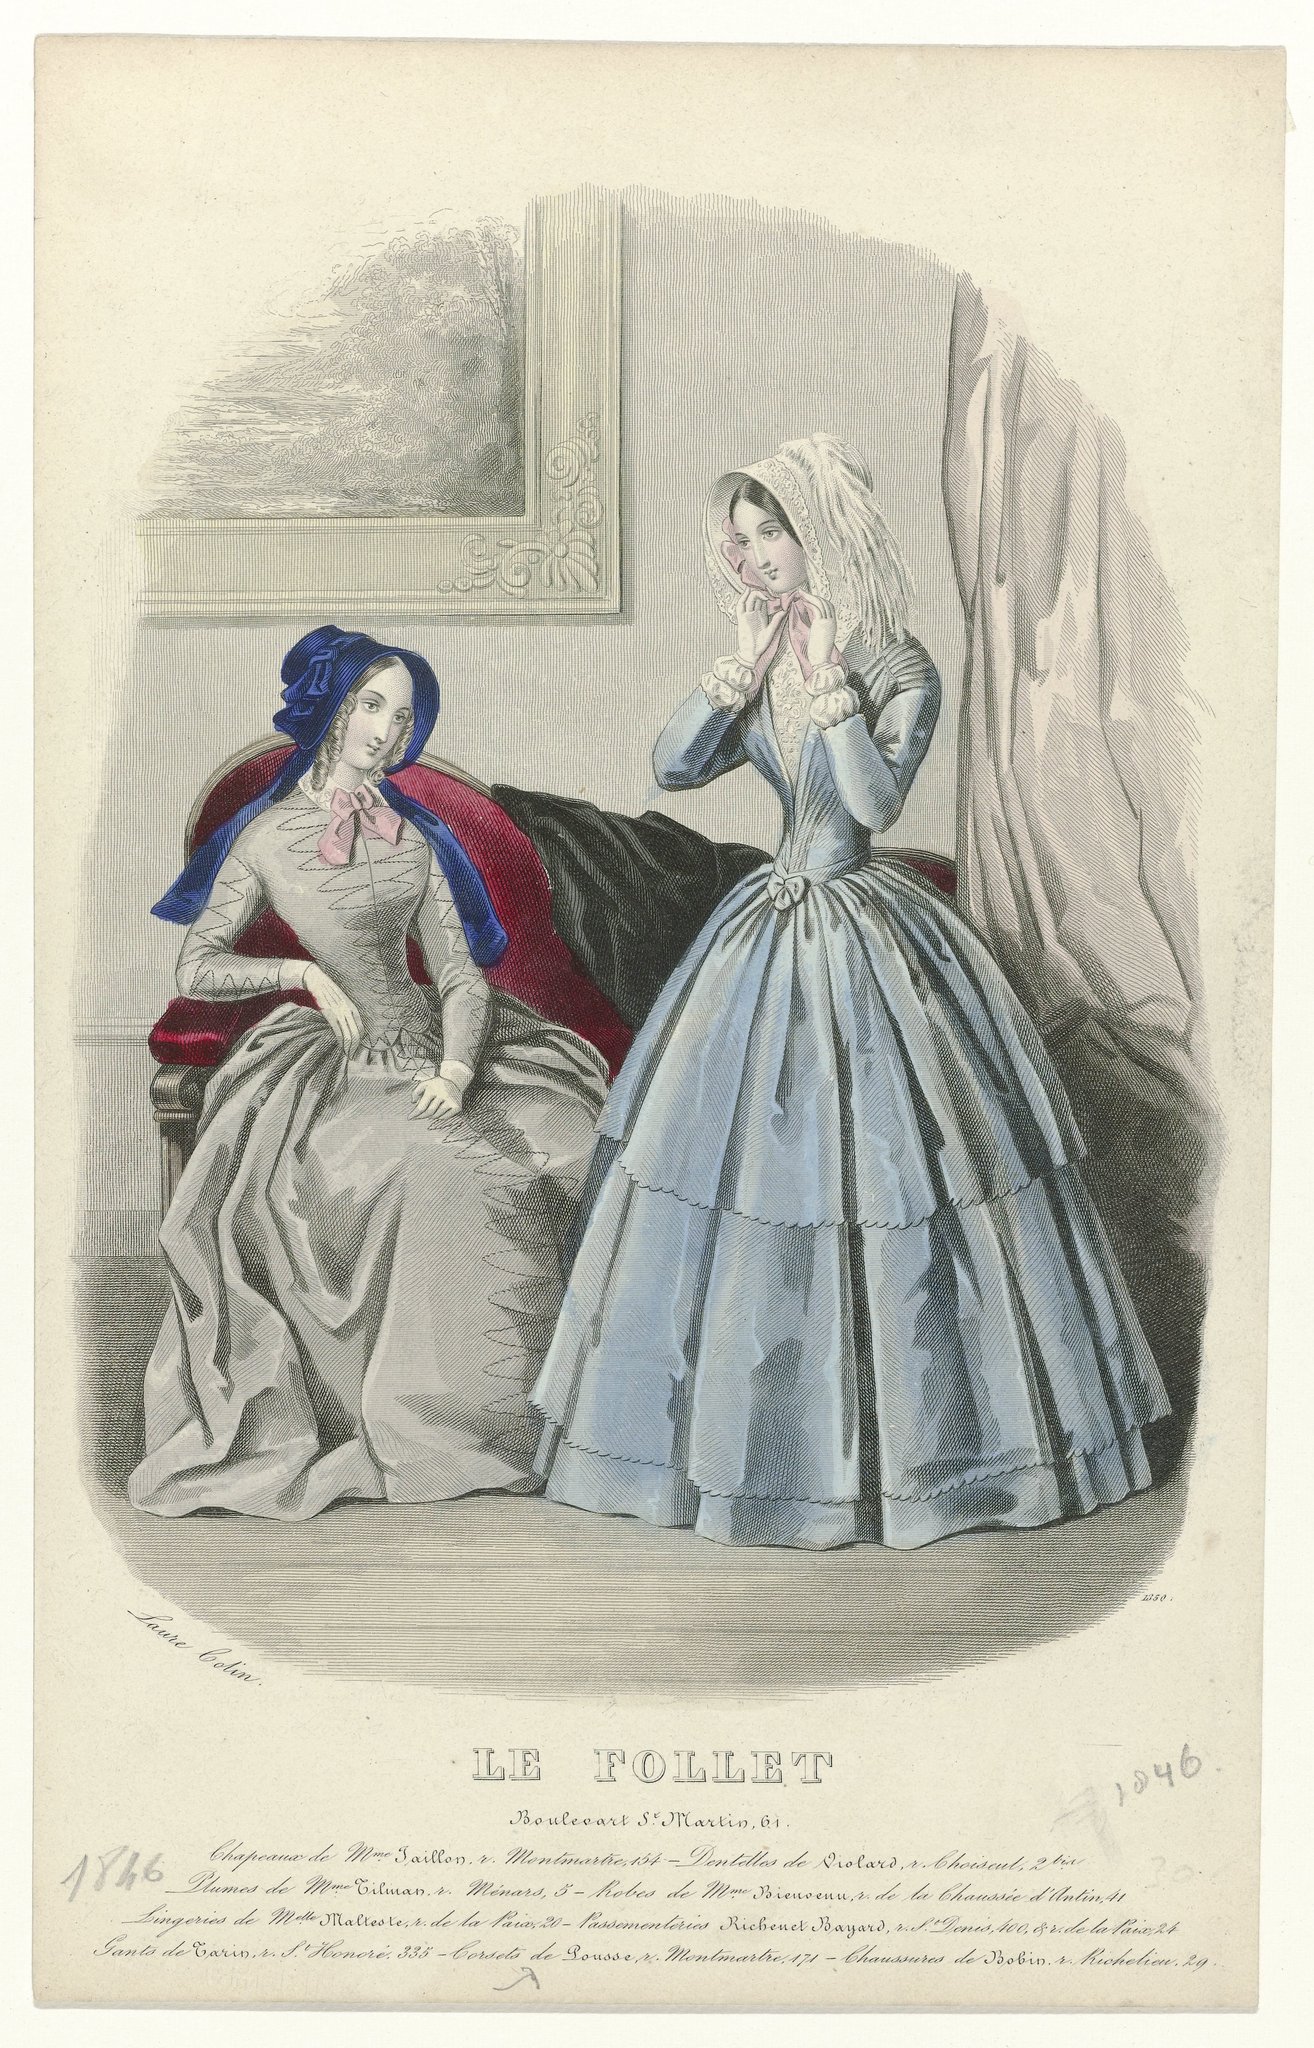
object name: fashion print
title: Le Follet, 1846, No. 1350 : Chapeaux de Mme Jaillon (...)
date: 1846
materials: paper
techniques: engraving, hand coloring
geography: paris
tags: ornamental parts of clothing (+ women's clothes), lace (+ women's clothes), fashion plates, head-gear: hat (+ women's clothes), shoes, sandals (+ women's clothes), gloves, mittens, etc. (+ women's clothes), dress, gown (+ women's clothes), couch, sofa, settee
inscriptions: caption: ‘Chapeaux de M.me Jaillon. r. Montmartre, 154 - Dentelles de Violard, r. Choiseul, 2 bis. Plumes de M.me Tilman, r. Ménars, 5- Robes de M.me Bienvenn, r. dela Chaussée d'Antin, 41 Lingeries de M.elle Malteste, r. de la Paix, 20_ Passementeries Richenet Bayard,r. S.t Denis, 4000 & r. de la Paix, 24 Gants de Tarin, r. S.t Honoré, 335- Corsets de Pousse, r. Montmartre, 171- Chaussures de Bobin, r. Richelieu, 29.’, address: ‘Boulevart S.t Martin, 61.’, title: ‘Le Follet’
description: Twee vrouwen in een interieur. Onder de voorstelling enkele regels reclametekst voor verschillende producten. Prent uit het modetijdschrift Le Follet Courrier des Salons (novembre 1829-octobre 1882).